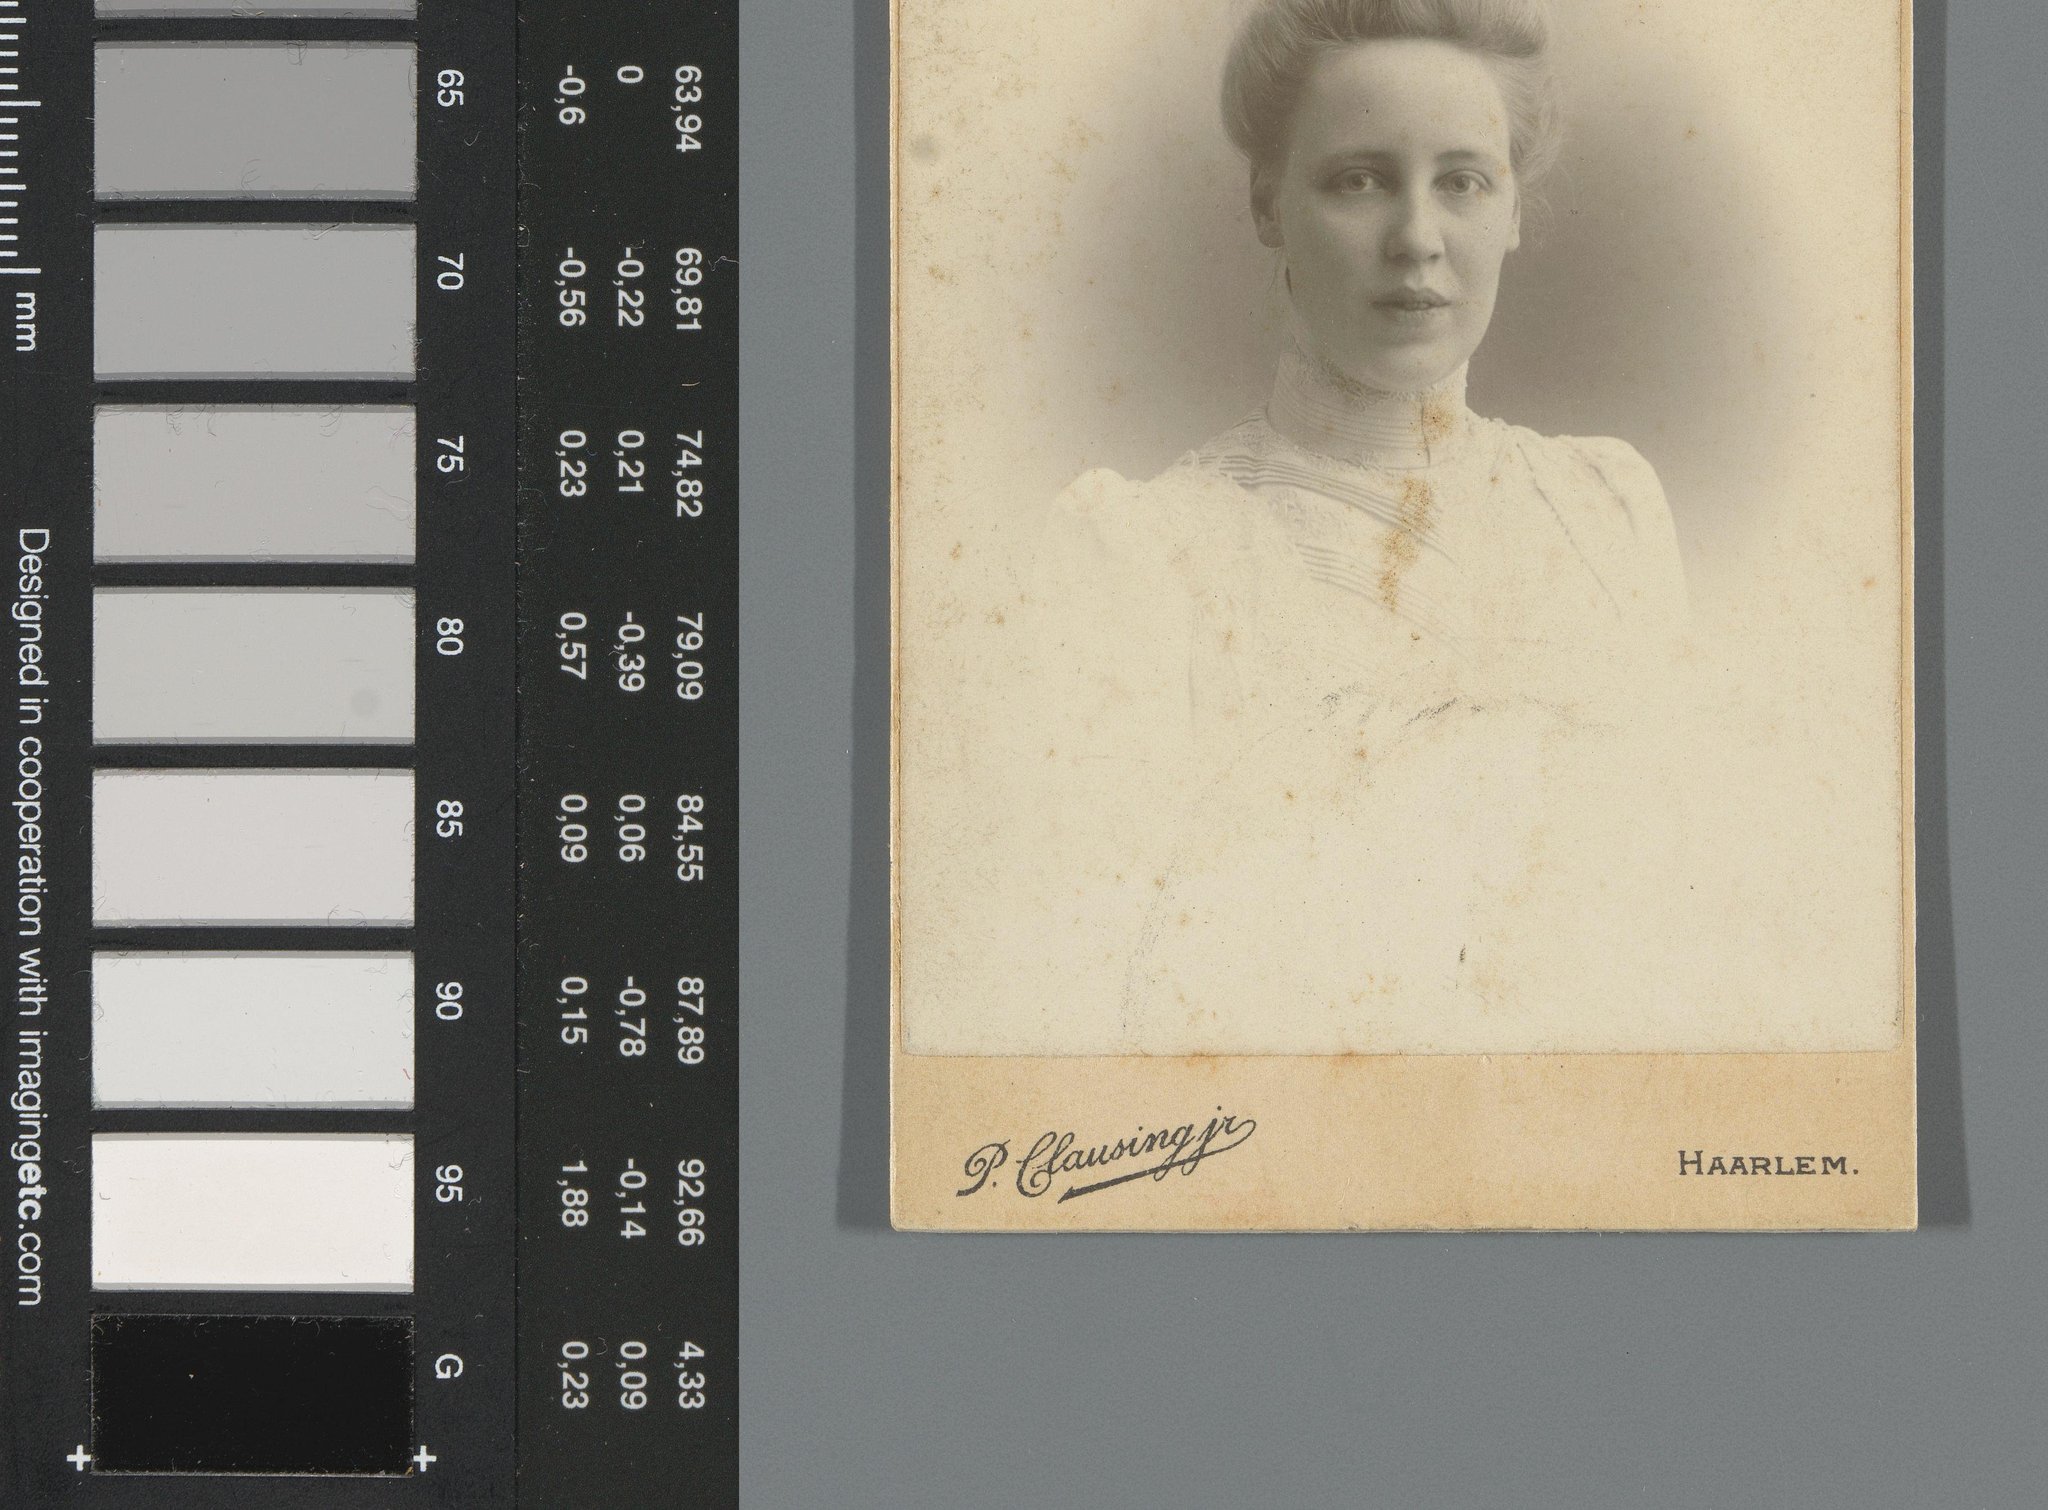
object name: photograph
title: Portret van Suze de Stuers-Teding van Berkhout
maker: peter clausing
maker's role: fotograaf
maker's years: 1870-1913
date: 1905-1910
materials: cardboard, photographic support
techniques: photography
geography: haarlem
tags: the hague, historical persons - bb - woman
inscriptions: annotation: ‘S. de Stuers-TvB’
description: Portret van Suze de Stuers-Teding van Berkhout.